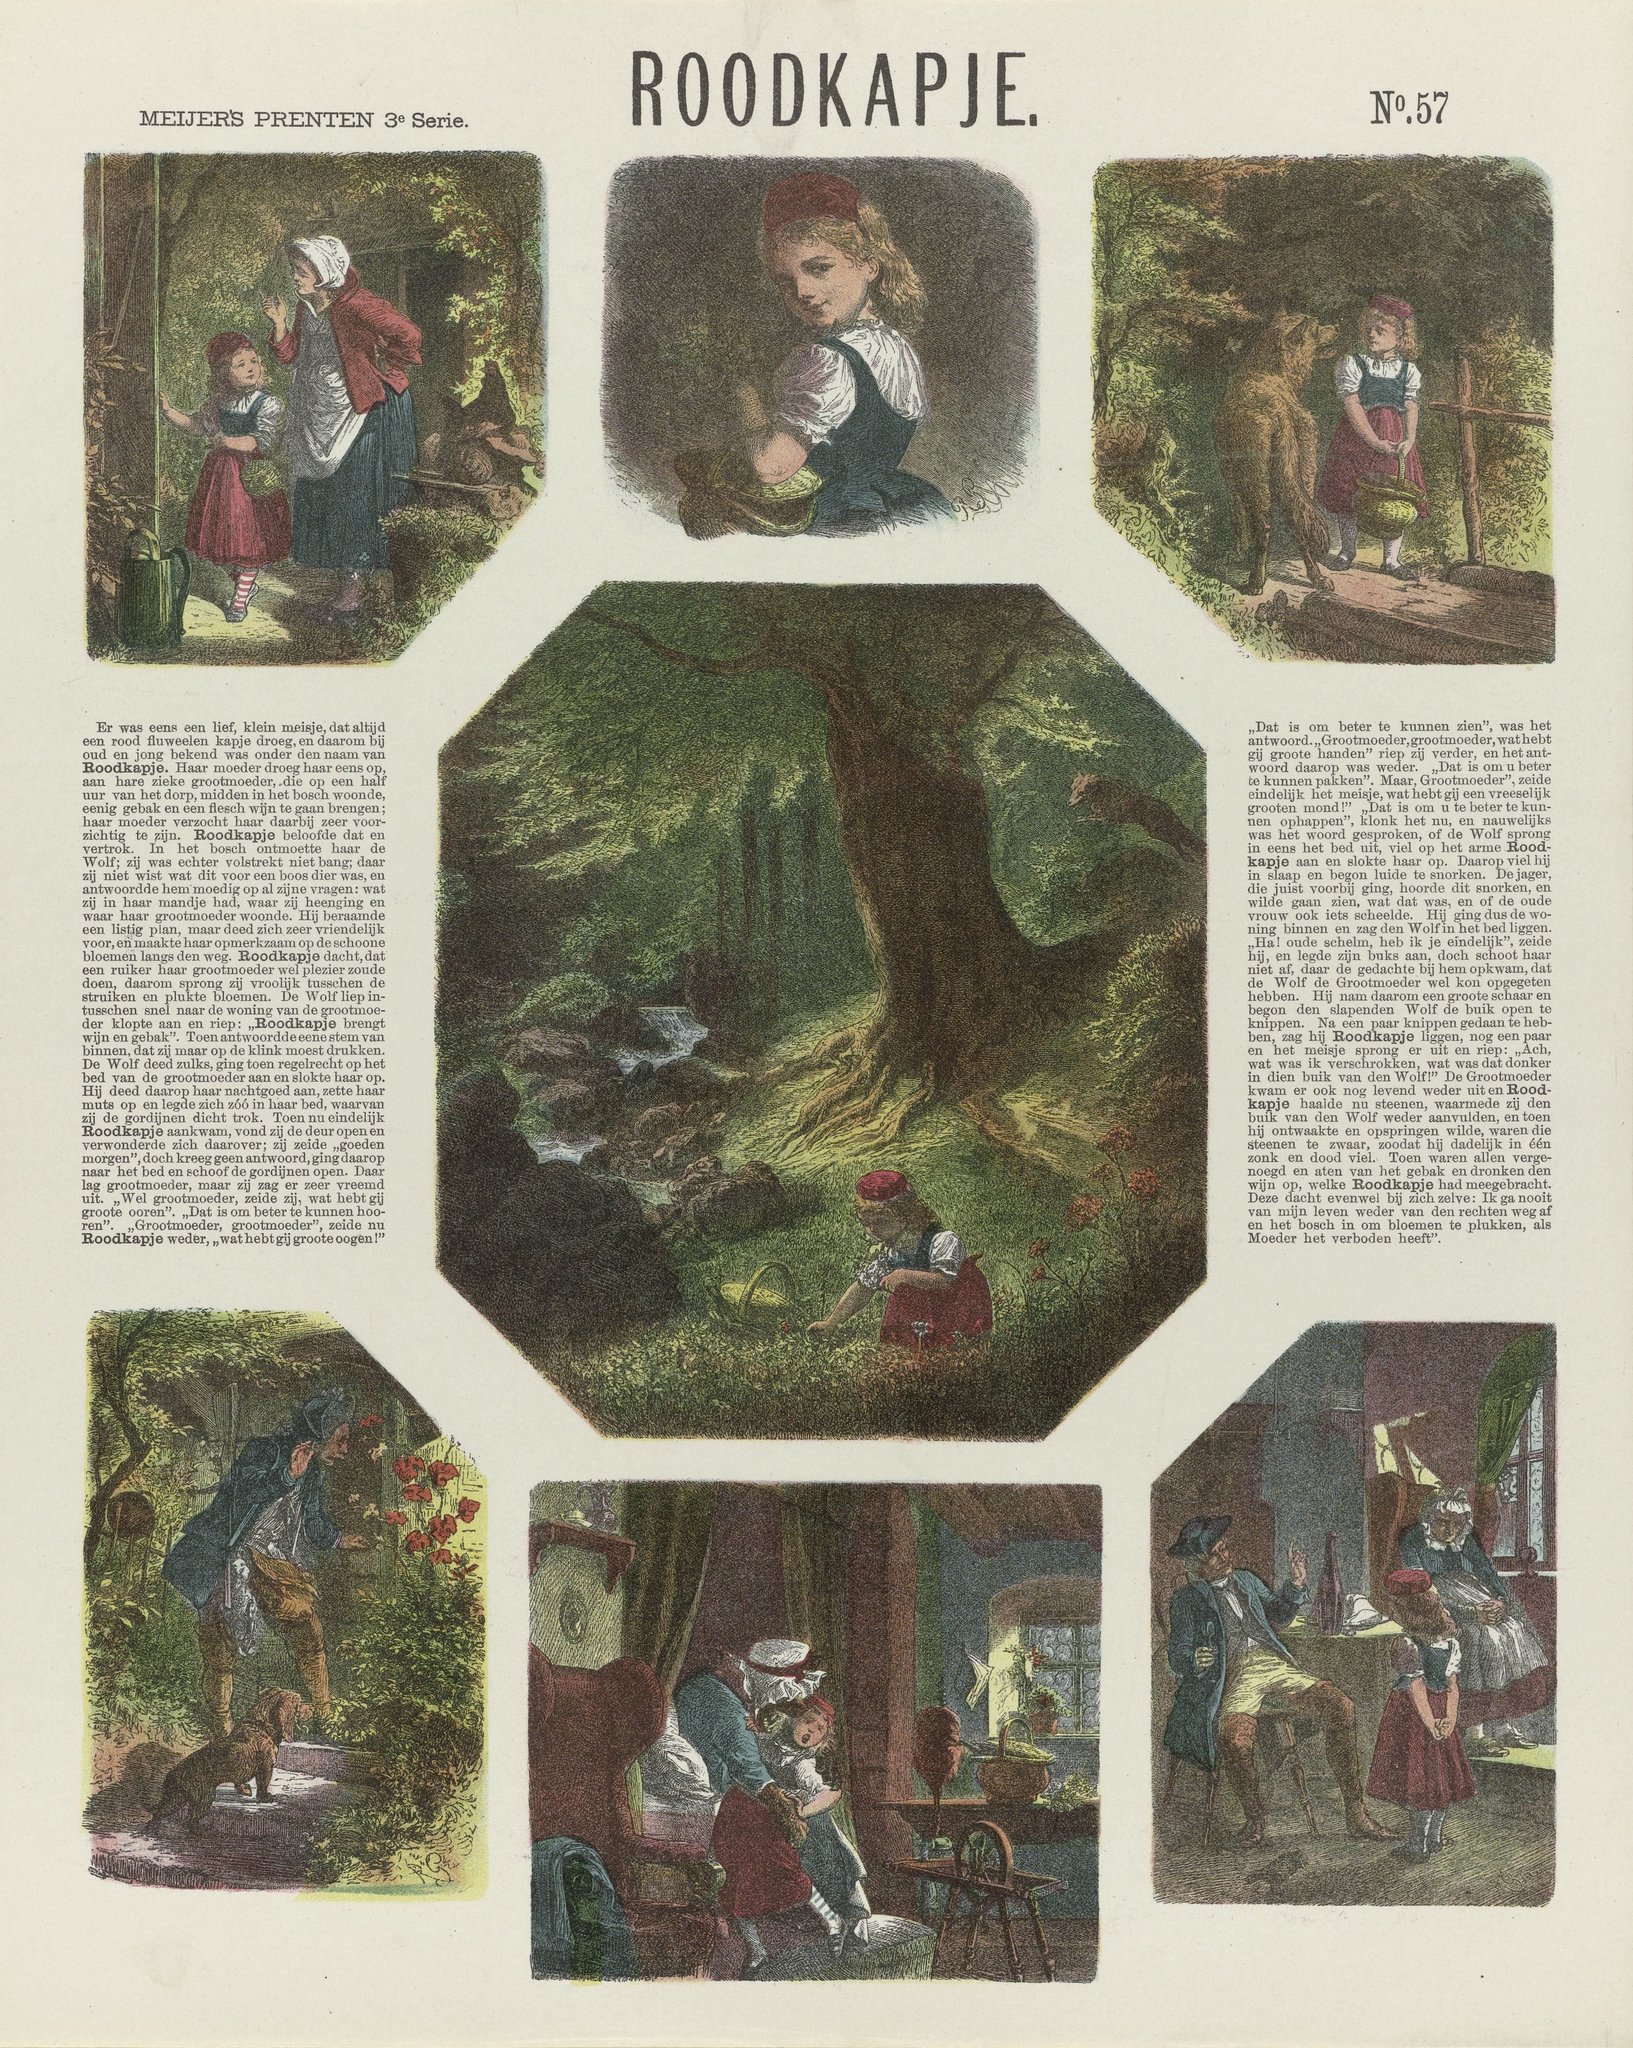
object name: popular print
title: Meijer's prenten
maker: Anonymous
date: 1878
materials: paper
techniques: lithograph, letterpress printing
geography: amsterdam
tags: tales and fairy tales: little red riding-hood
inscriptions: collector's mark: Lugt 2760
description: Blad met 7 voorstellingen uit het sprookje van Roodkapje. Twee blokken met tekst links en rechts. Genummerd rechtsboven: No. 57.